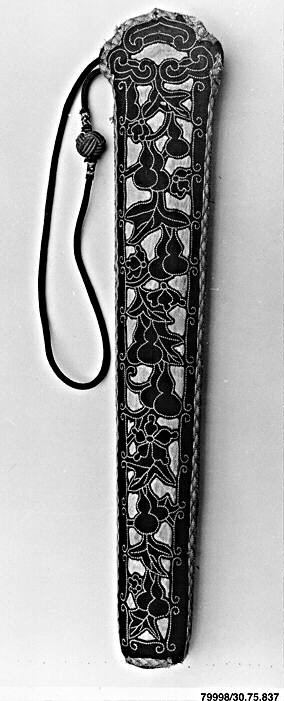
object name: fan holder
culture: chinese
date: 1701-1900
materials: silk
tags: gourds